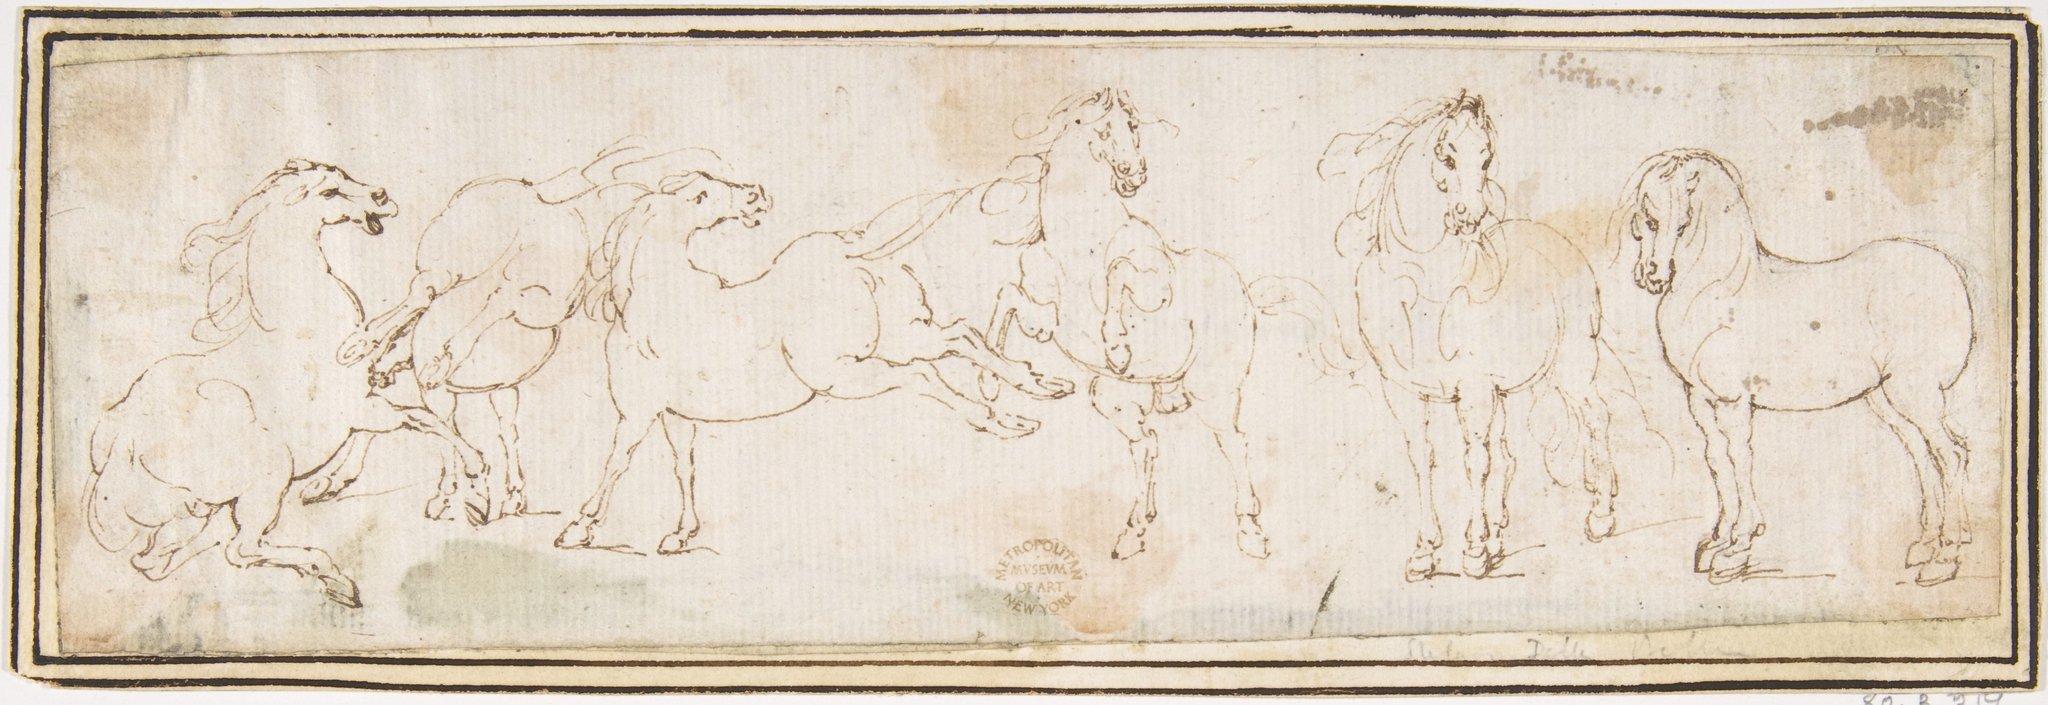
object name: drawing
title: Six Horses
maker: francesco allegrini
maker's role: artist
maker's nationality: italian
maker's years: 1615-1679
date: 1624-1663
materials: ink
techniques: pen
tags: horses